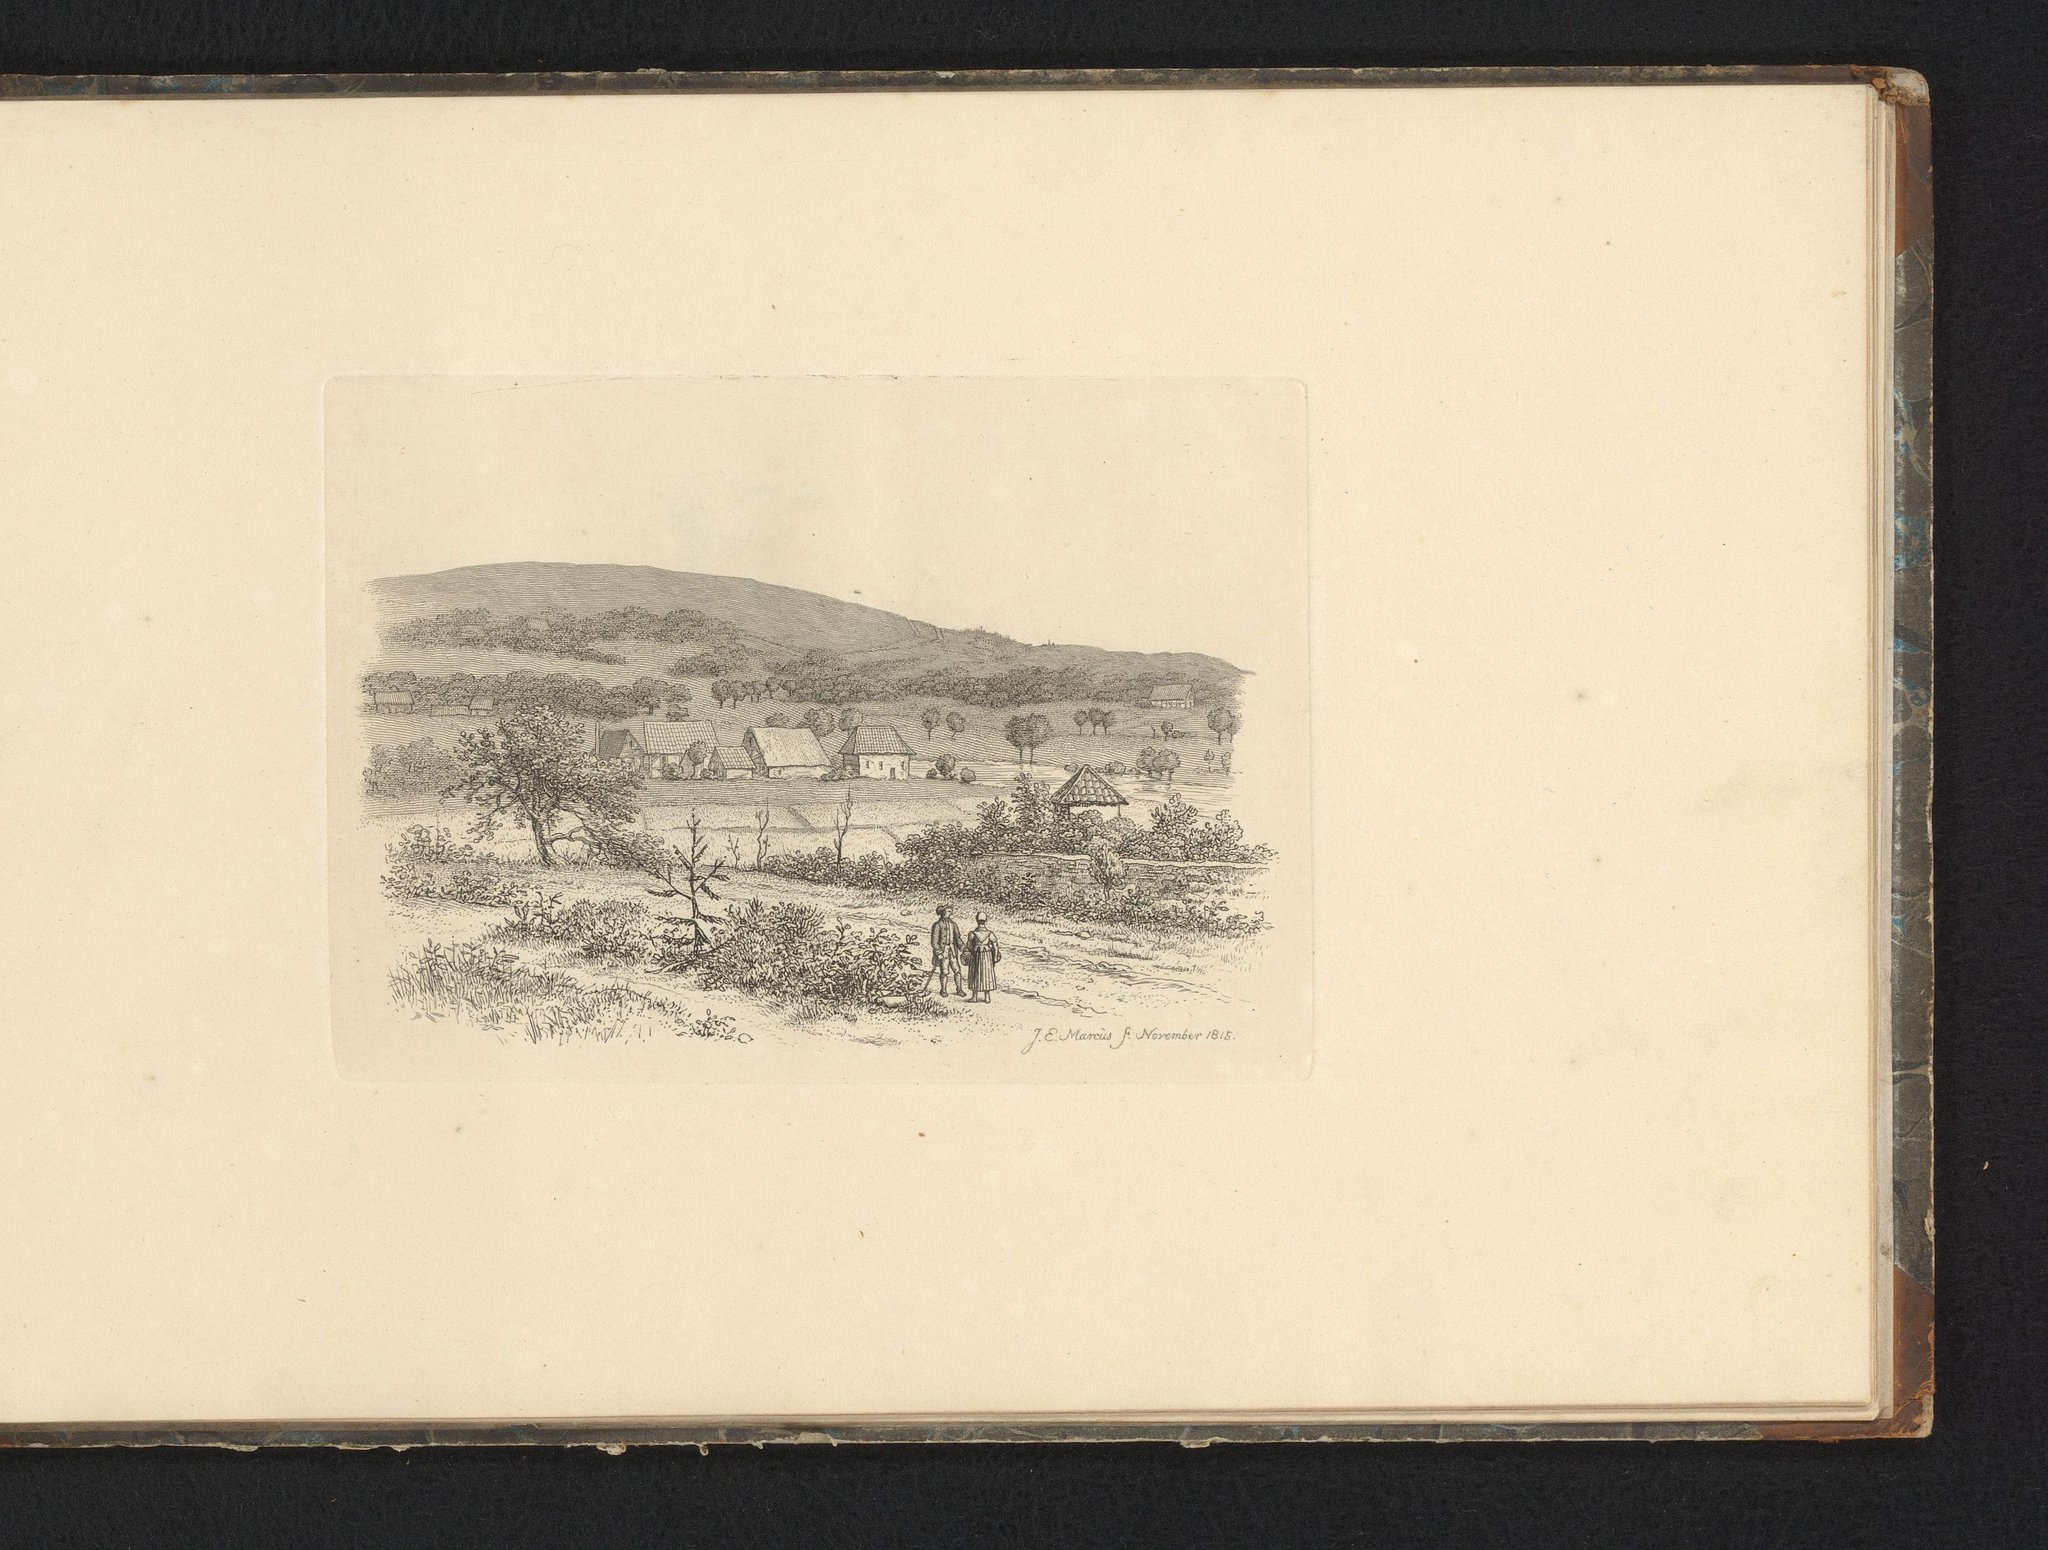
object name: album leaf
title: Studiebeelden en fragmenten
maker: jacob ernst marcus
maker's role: draughtsman, print maker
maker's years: 1774-1826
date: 1811-1815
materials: paper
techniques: etching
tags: dale, valley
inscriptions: date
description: Deze prent maakt deel uit van een album.